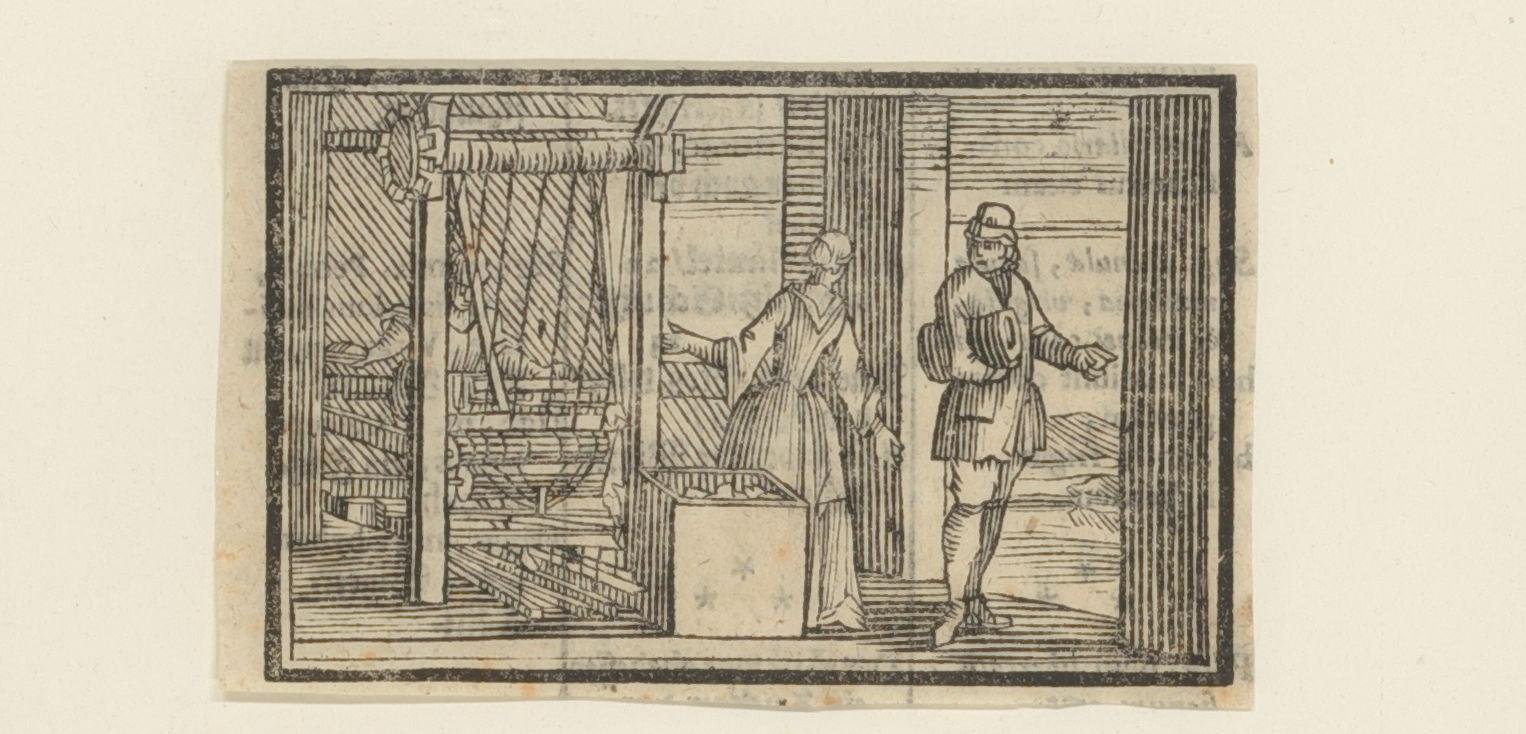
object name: print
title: Vrouw aan het werk bij een weefgetouw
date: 1719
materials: paper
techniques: letterpress printing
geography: nuremberg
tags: handicrafts, craftsman at work, weaving, textile fabric, cloth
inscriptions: collector's mark: Lugt 1641, stamp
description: Prent uit: Comenius, Johannes Amosius. Orbis sensualium picti pars prima (...). Neurenberg: Martin Endter, 1719, dl. 2, p. 176. Prent eerder gebruikt in: Comenius, Johannes Amosius. Orbis Sensualium Picti denuo aucti Pars Secunda (...). Neurenberg: Martin Endter, 1730, dl. 2.